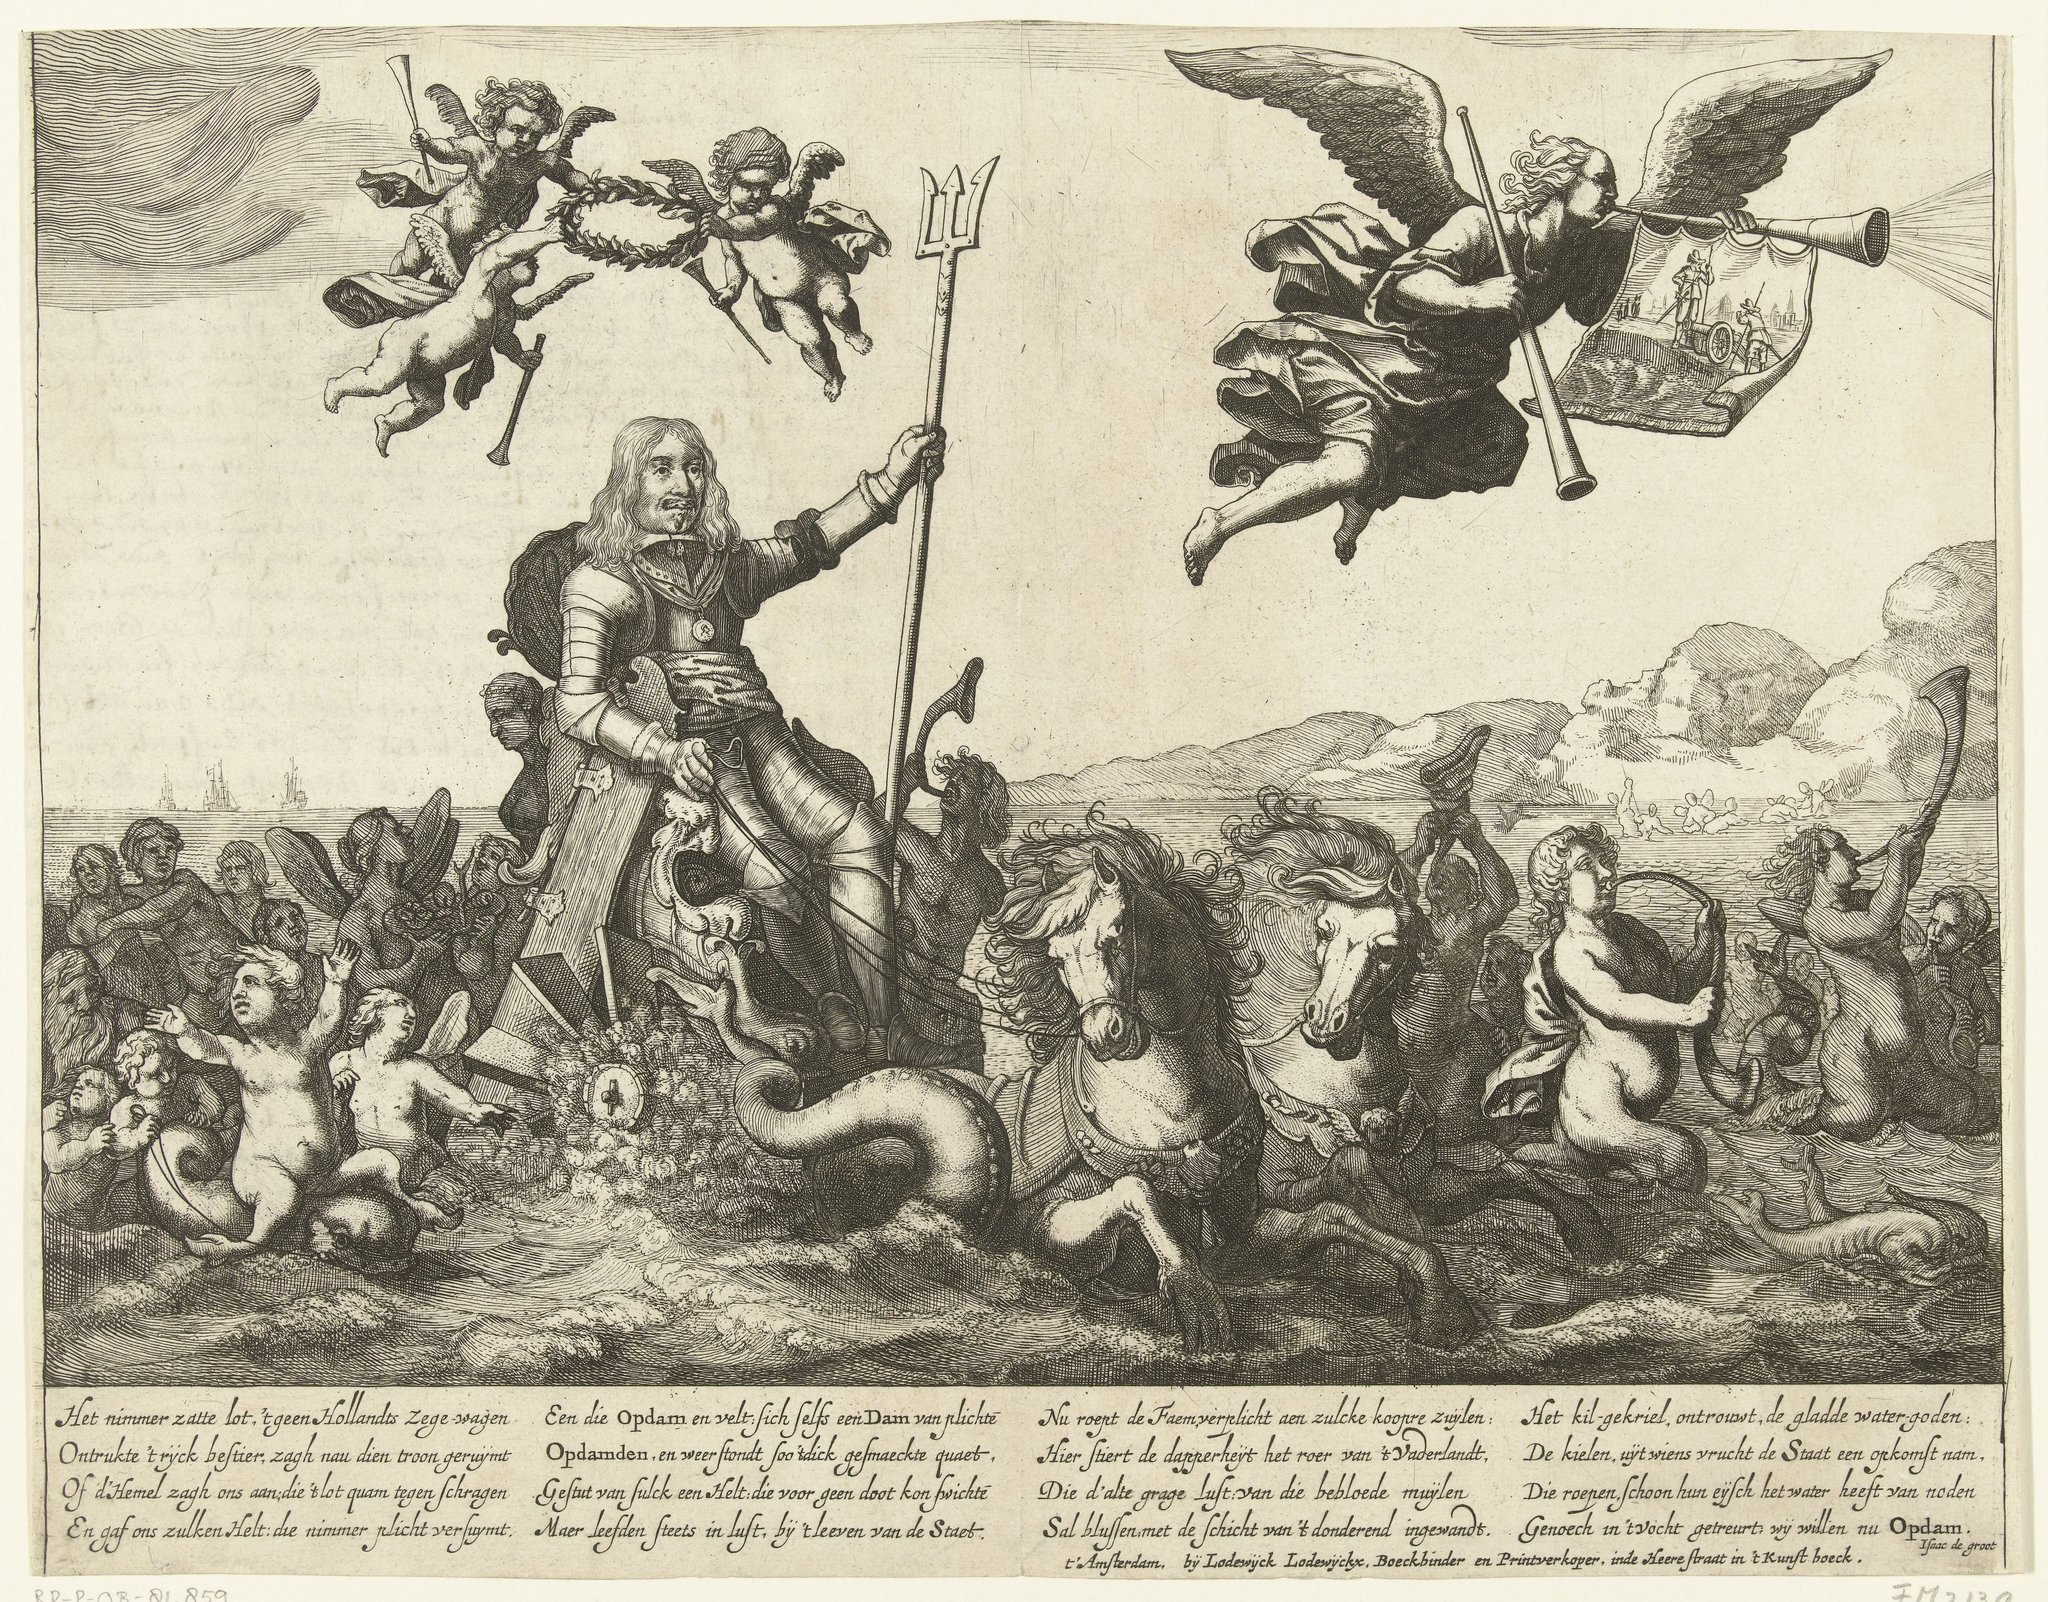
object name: propagandaprent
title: Allegorie op de overwinning van de baron van Wassenaer in de Slag in de Sont, 1658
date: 1658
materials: paper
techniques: engraving, etching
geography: amsterdam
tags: jacob baron van wassenaer heer van obdam, symbolic triumphs of individual persons, fame; 'fama', 'fama buona', 'fama chiara' (ripa)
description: Allegorie op de overwinning van de baron van Wassenaer in de Slag in de Sont, zeeslag tussen de Staatse vloot onder admiraal Jacob baron van Wassenaer, heer van Obdam, en de Zweedse vloot onder admiraal Carl Gustaf Wrangel, 8 november 1658. Jacob baron van Wassenaer zittend in een door zeepaarden getrokken triomfwagen, in de handen een drietand en een roer, in het water omringd door tritons. In de blaast de Faam het nieuws van de overwinning. in het onderschrift 4 verzen van 4 regels. Op de achterkant een deel van een handschrift.